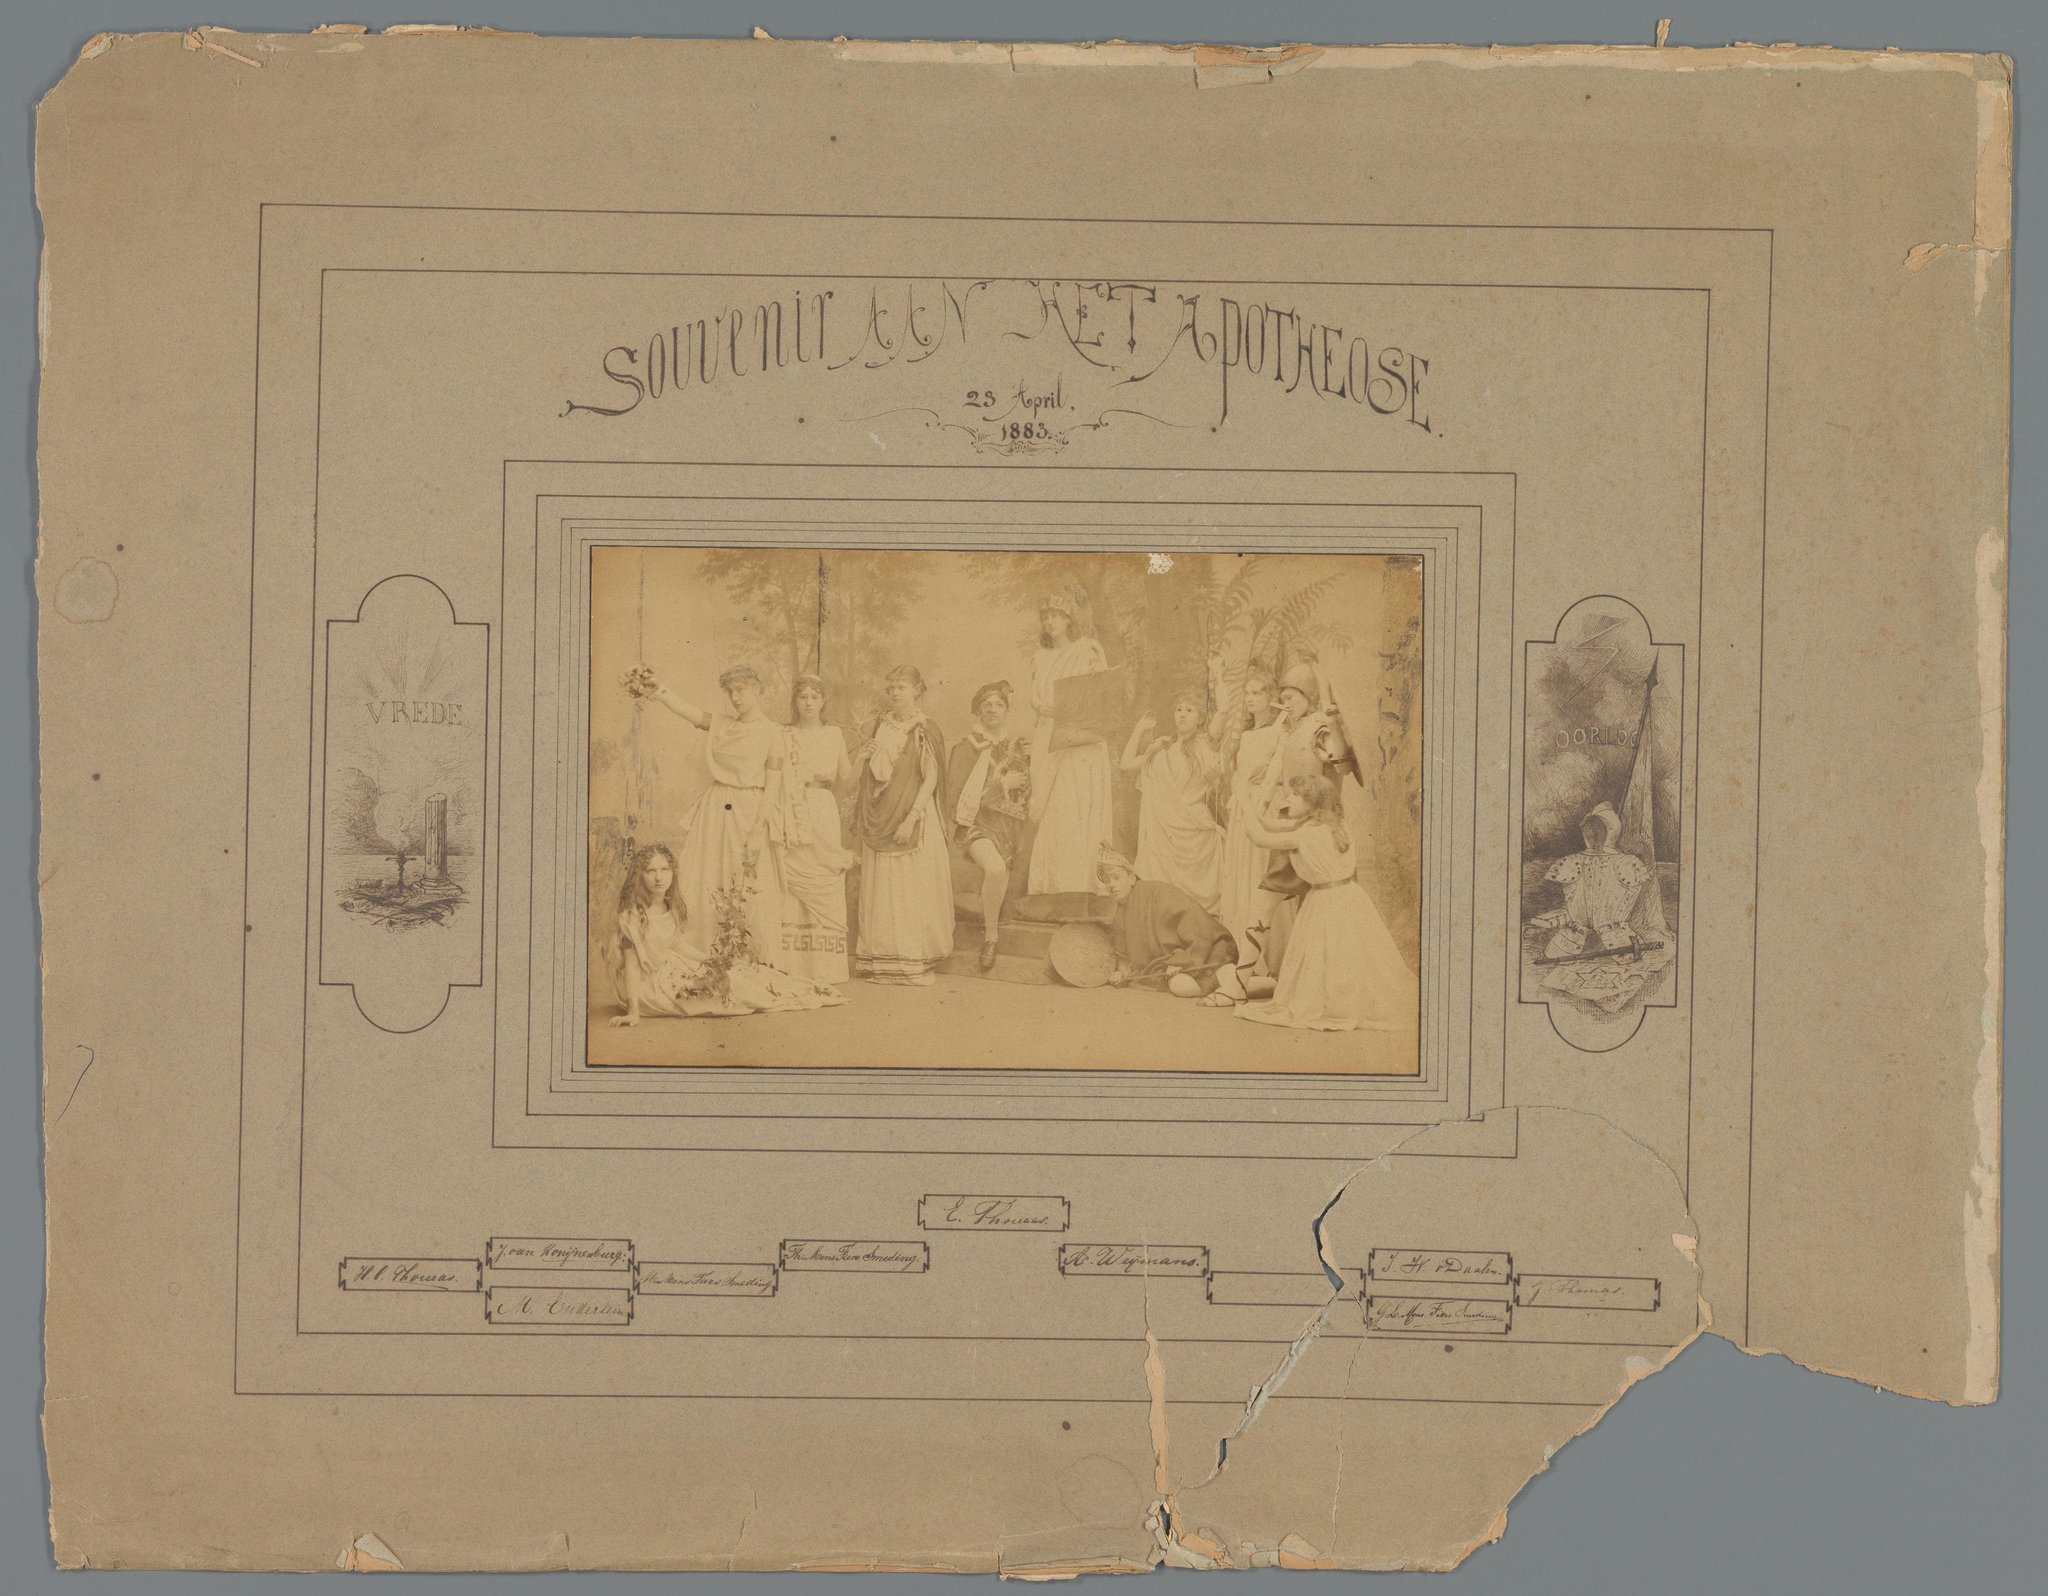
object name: photograph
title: Groepsportret van onbekende jongeren in historische kostuums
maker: Anonymous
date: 1883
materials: cardboard, ink, paper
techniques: albumen print, pen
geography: netherlands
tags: historical costume, anonymous historical persons portrayed in a group, in a group-portrait, netherlands